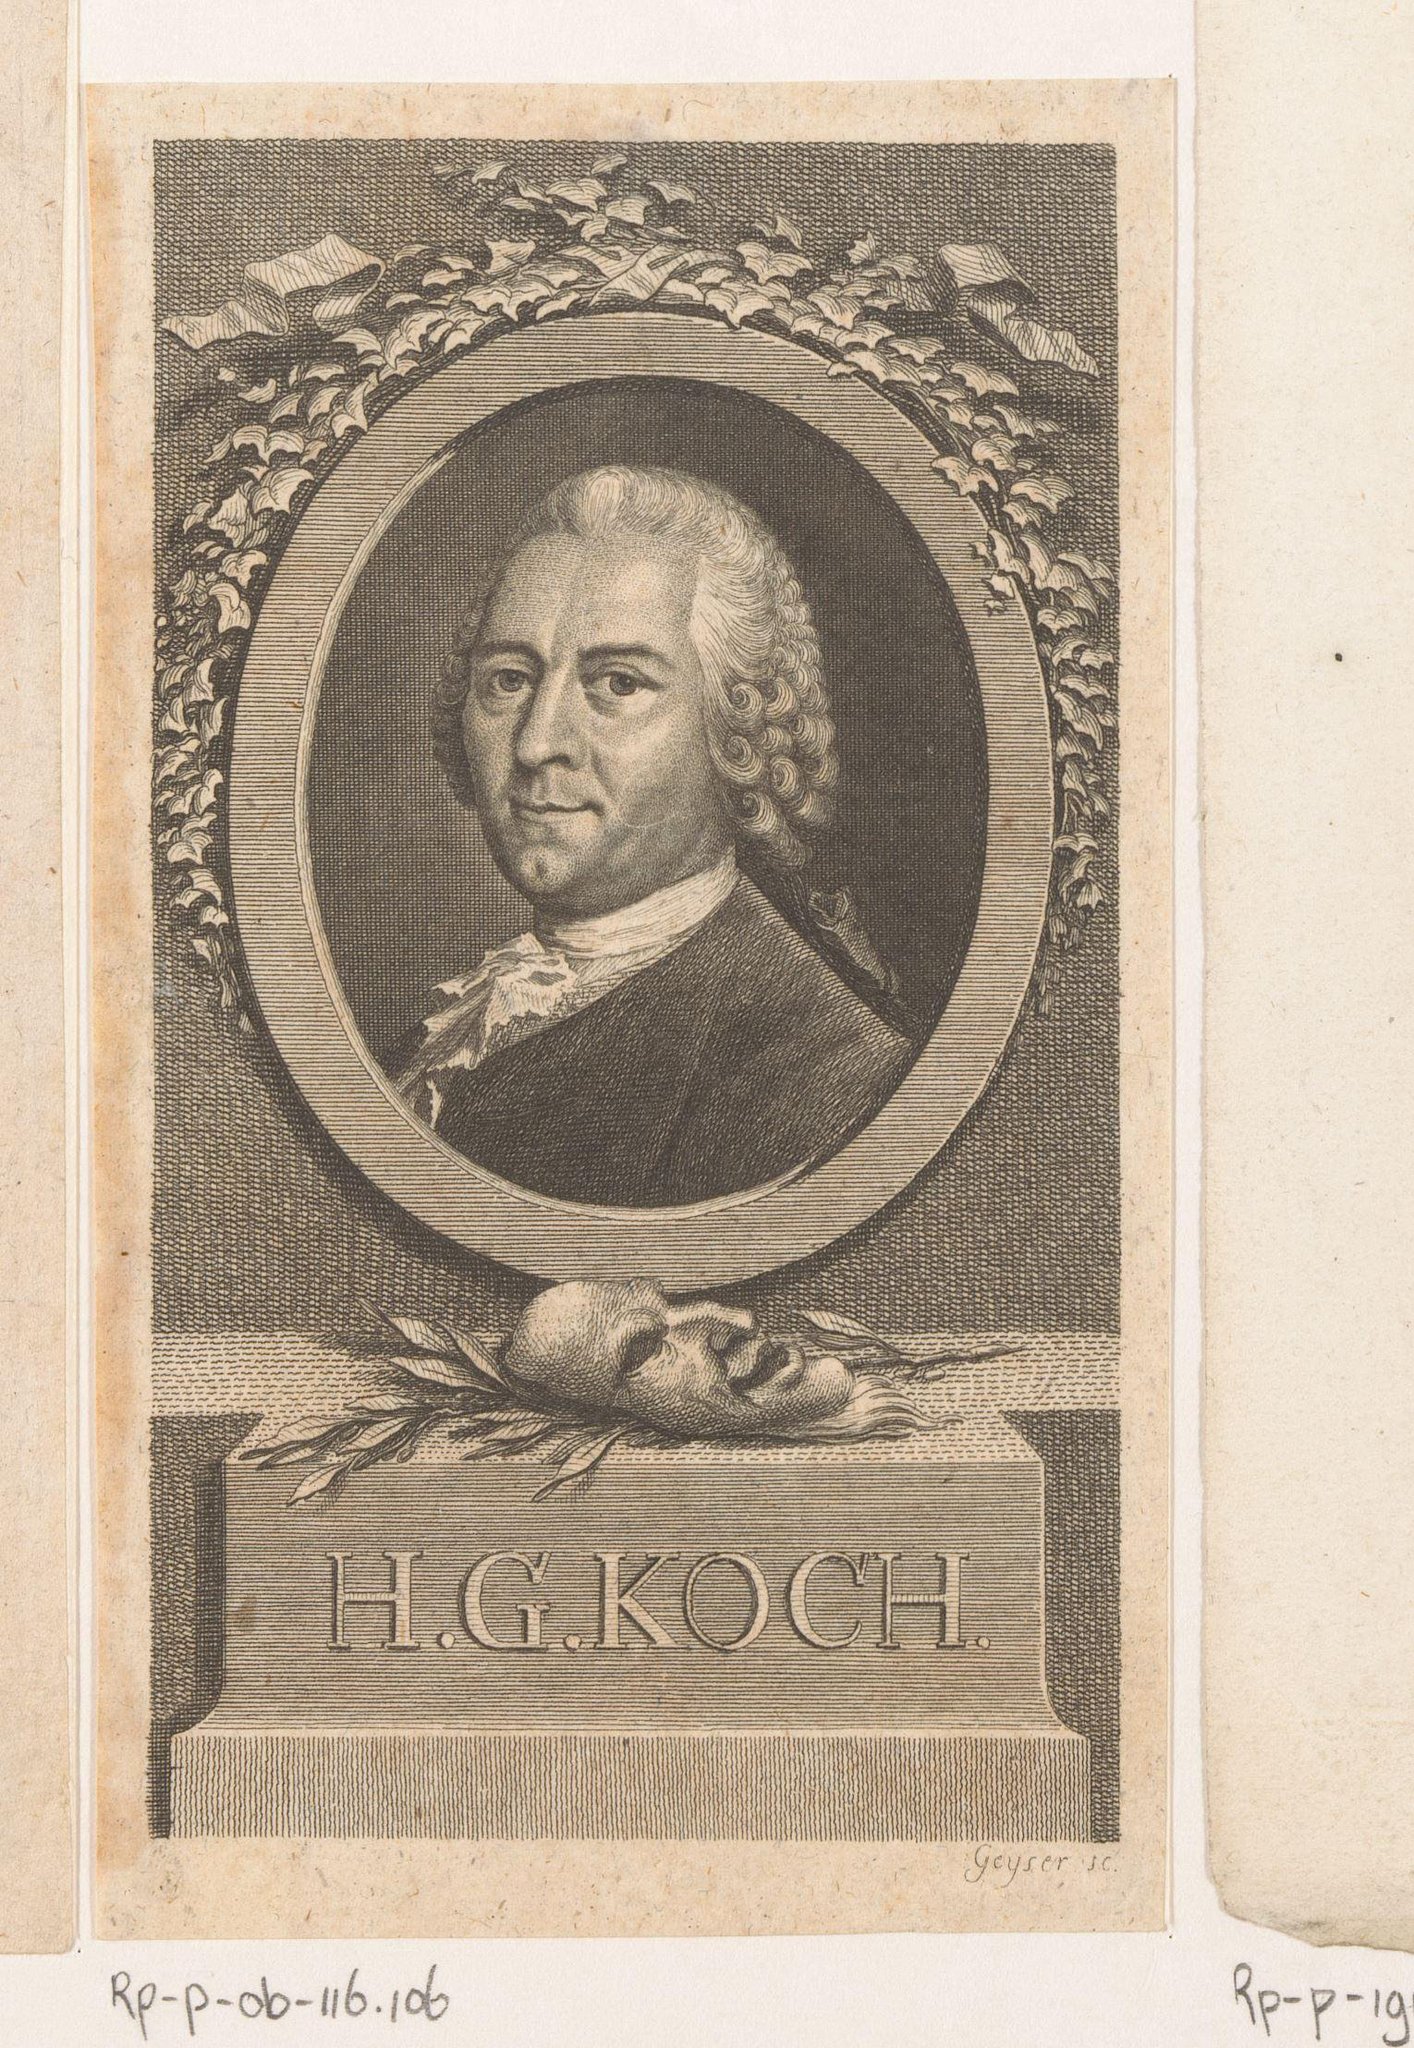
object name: print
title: Portret van Heinrich Gottfried Koch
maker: christian gottlieb geyser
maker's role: print maker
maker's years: 1742-1803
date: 1752-1803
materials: paper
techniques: engraving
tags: berlin, mask, historical persons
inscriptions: collector's mark: Lugt 2228